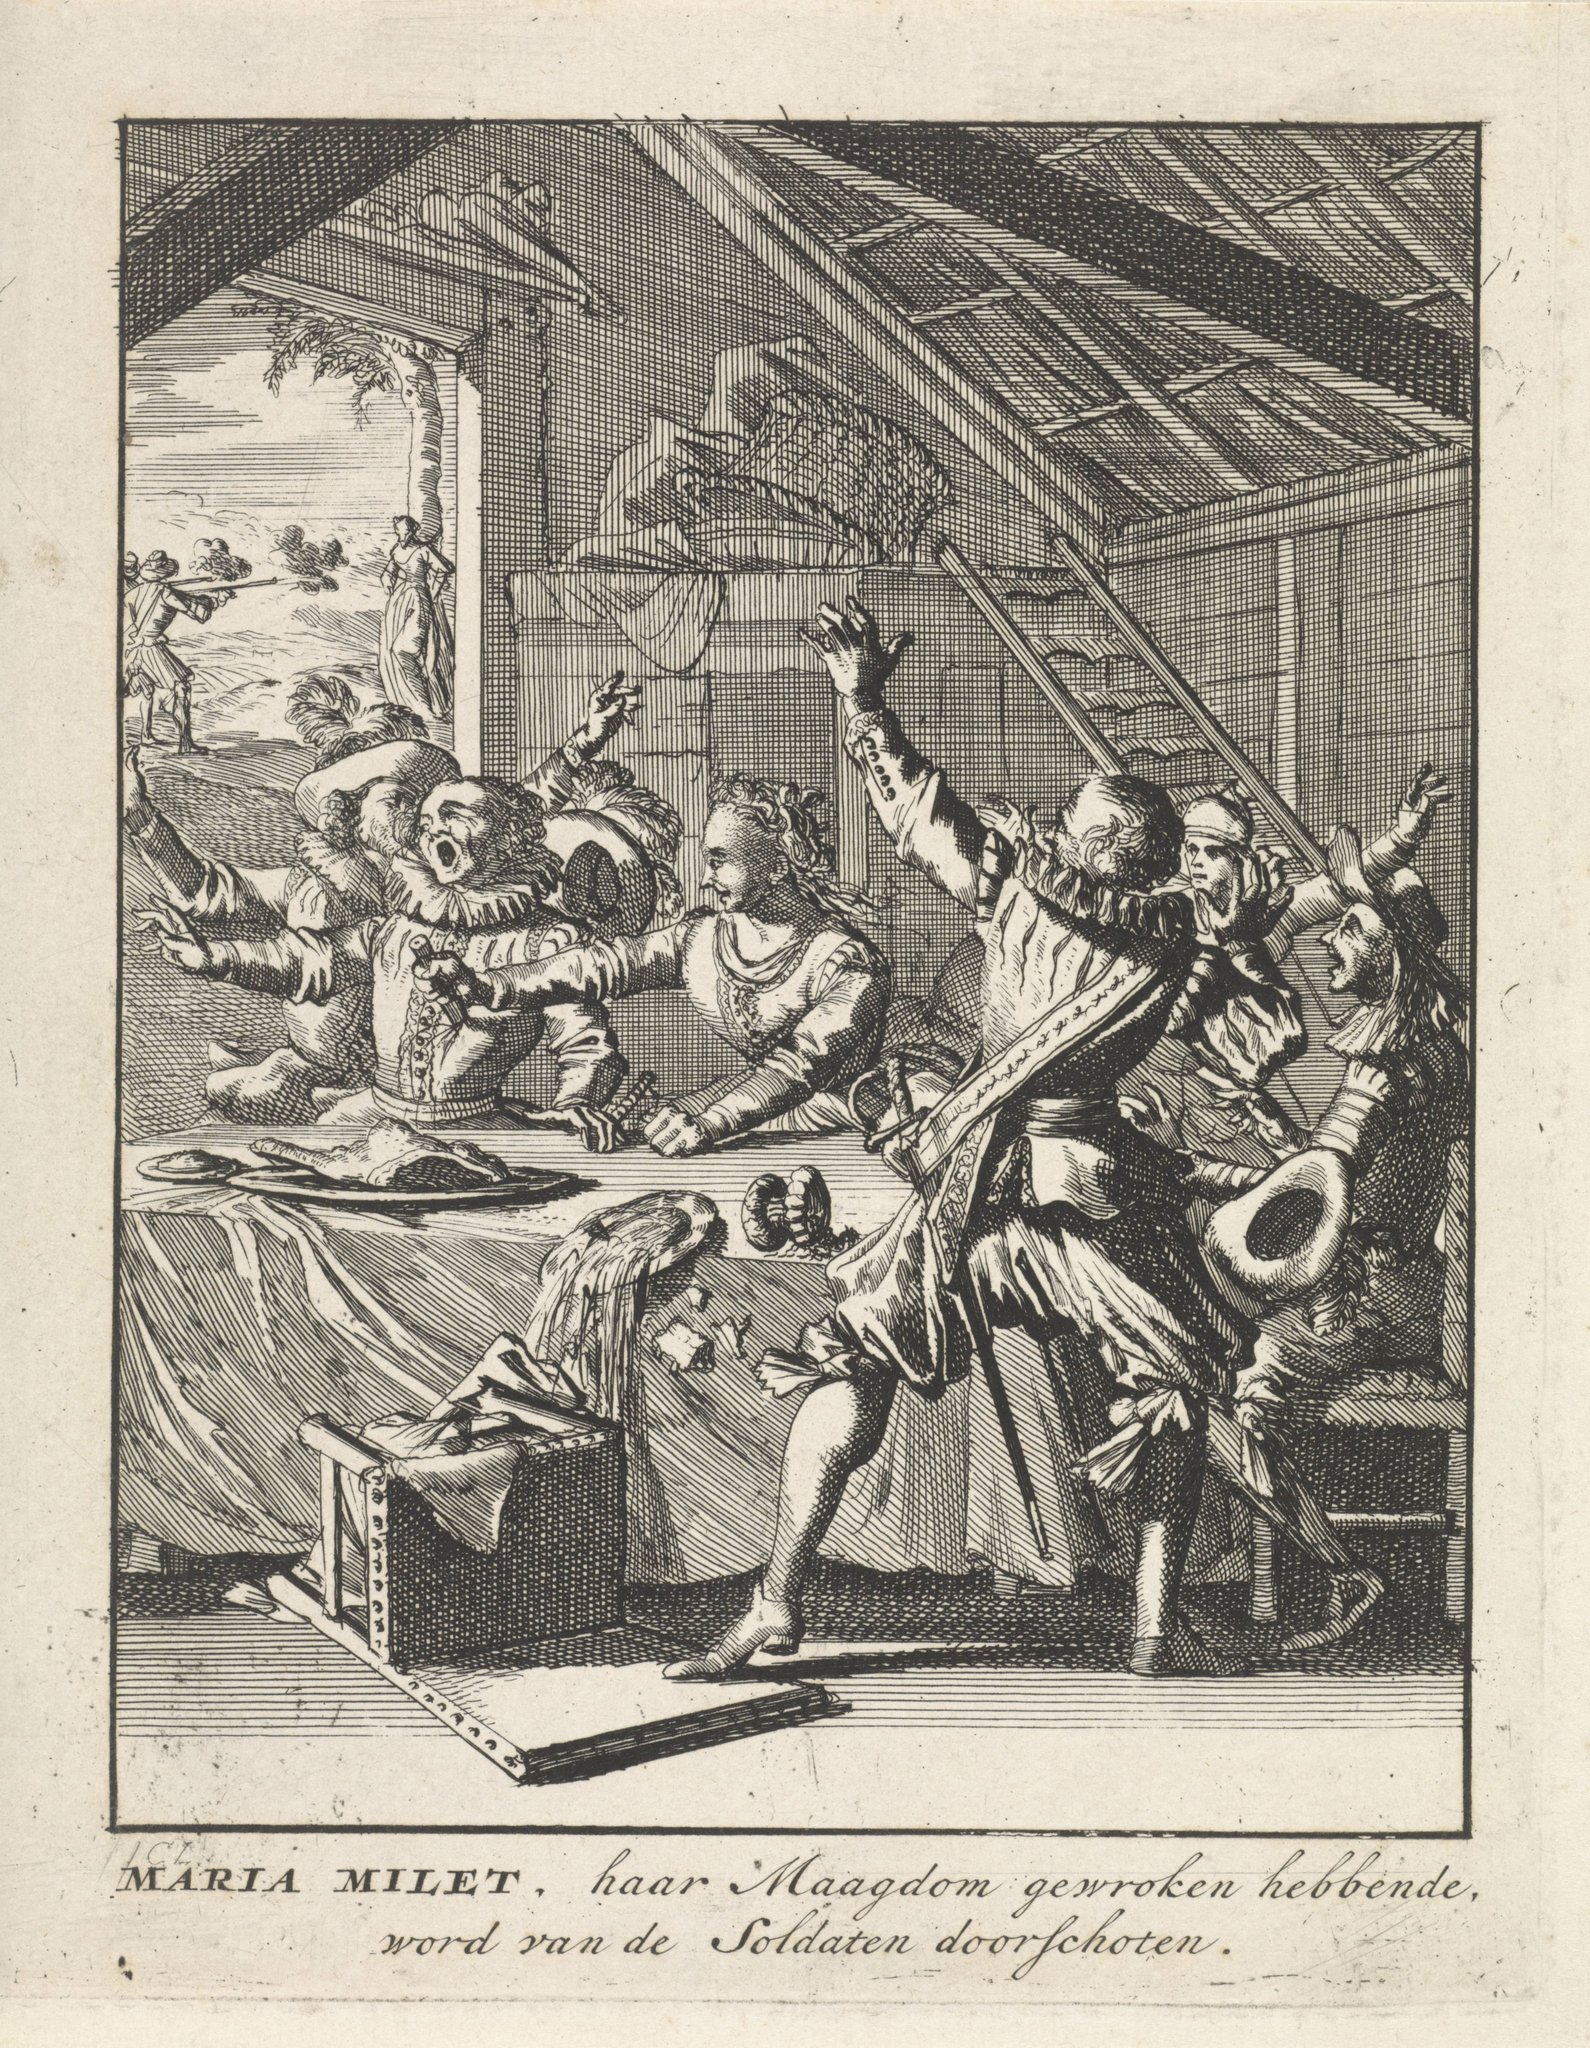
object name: history print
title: Maria Milet, haar Maagdom gewroken hebbende, word van de Soldaten doorschoten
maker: jan luyken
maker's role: draughtsman, print maker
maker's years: 1649-1712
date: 1699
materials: paper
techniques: etching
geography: amsterdam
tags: rape, violation, violent death, being killed; being mishandled and maltreated; seeking death, violent death by fusillade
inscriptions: collector's mark: Lugt 2228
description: Maria Milet zit samen met enkele soldaten rondom een tafel. Maria doodt een soldaat met een mes tijdens ce maaltijd. Wellicht uit wraak voor haar verkrachting door Spaanse soldaten tijdens de inname van Maastricht op 29 juni 1579. Op de achtergrond wordt zij terechtgesteld.